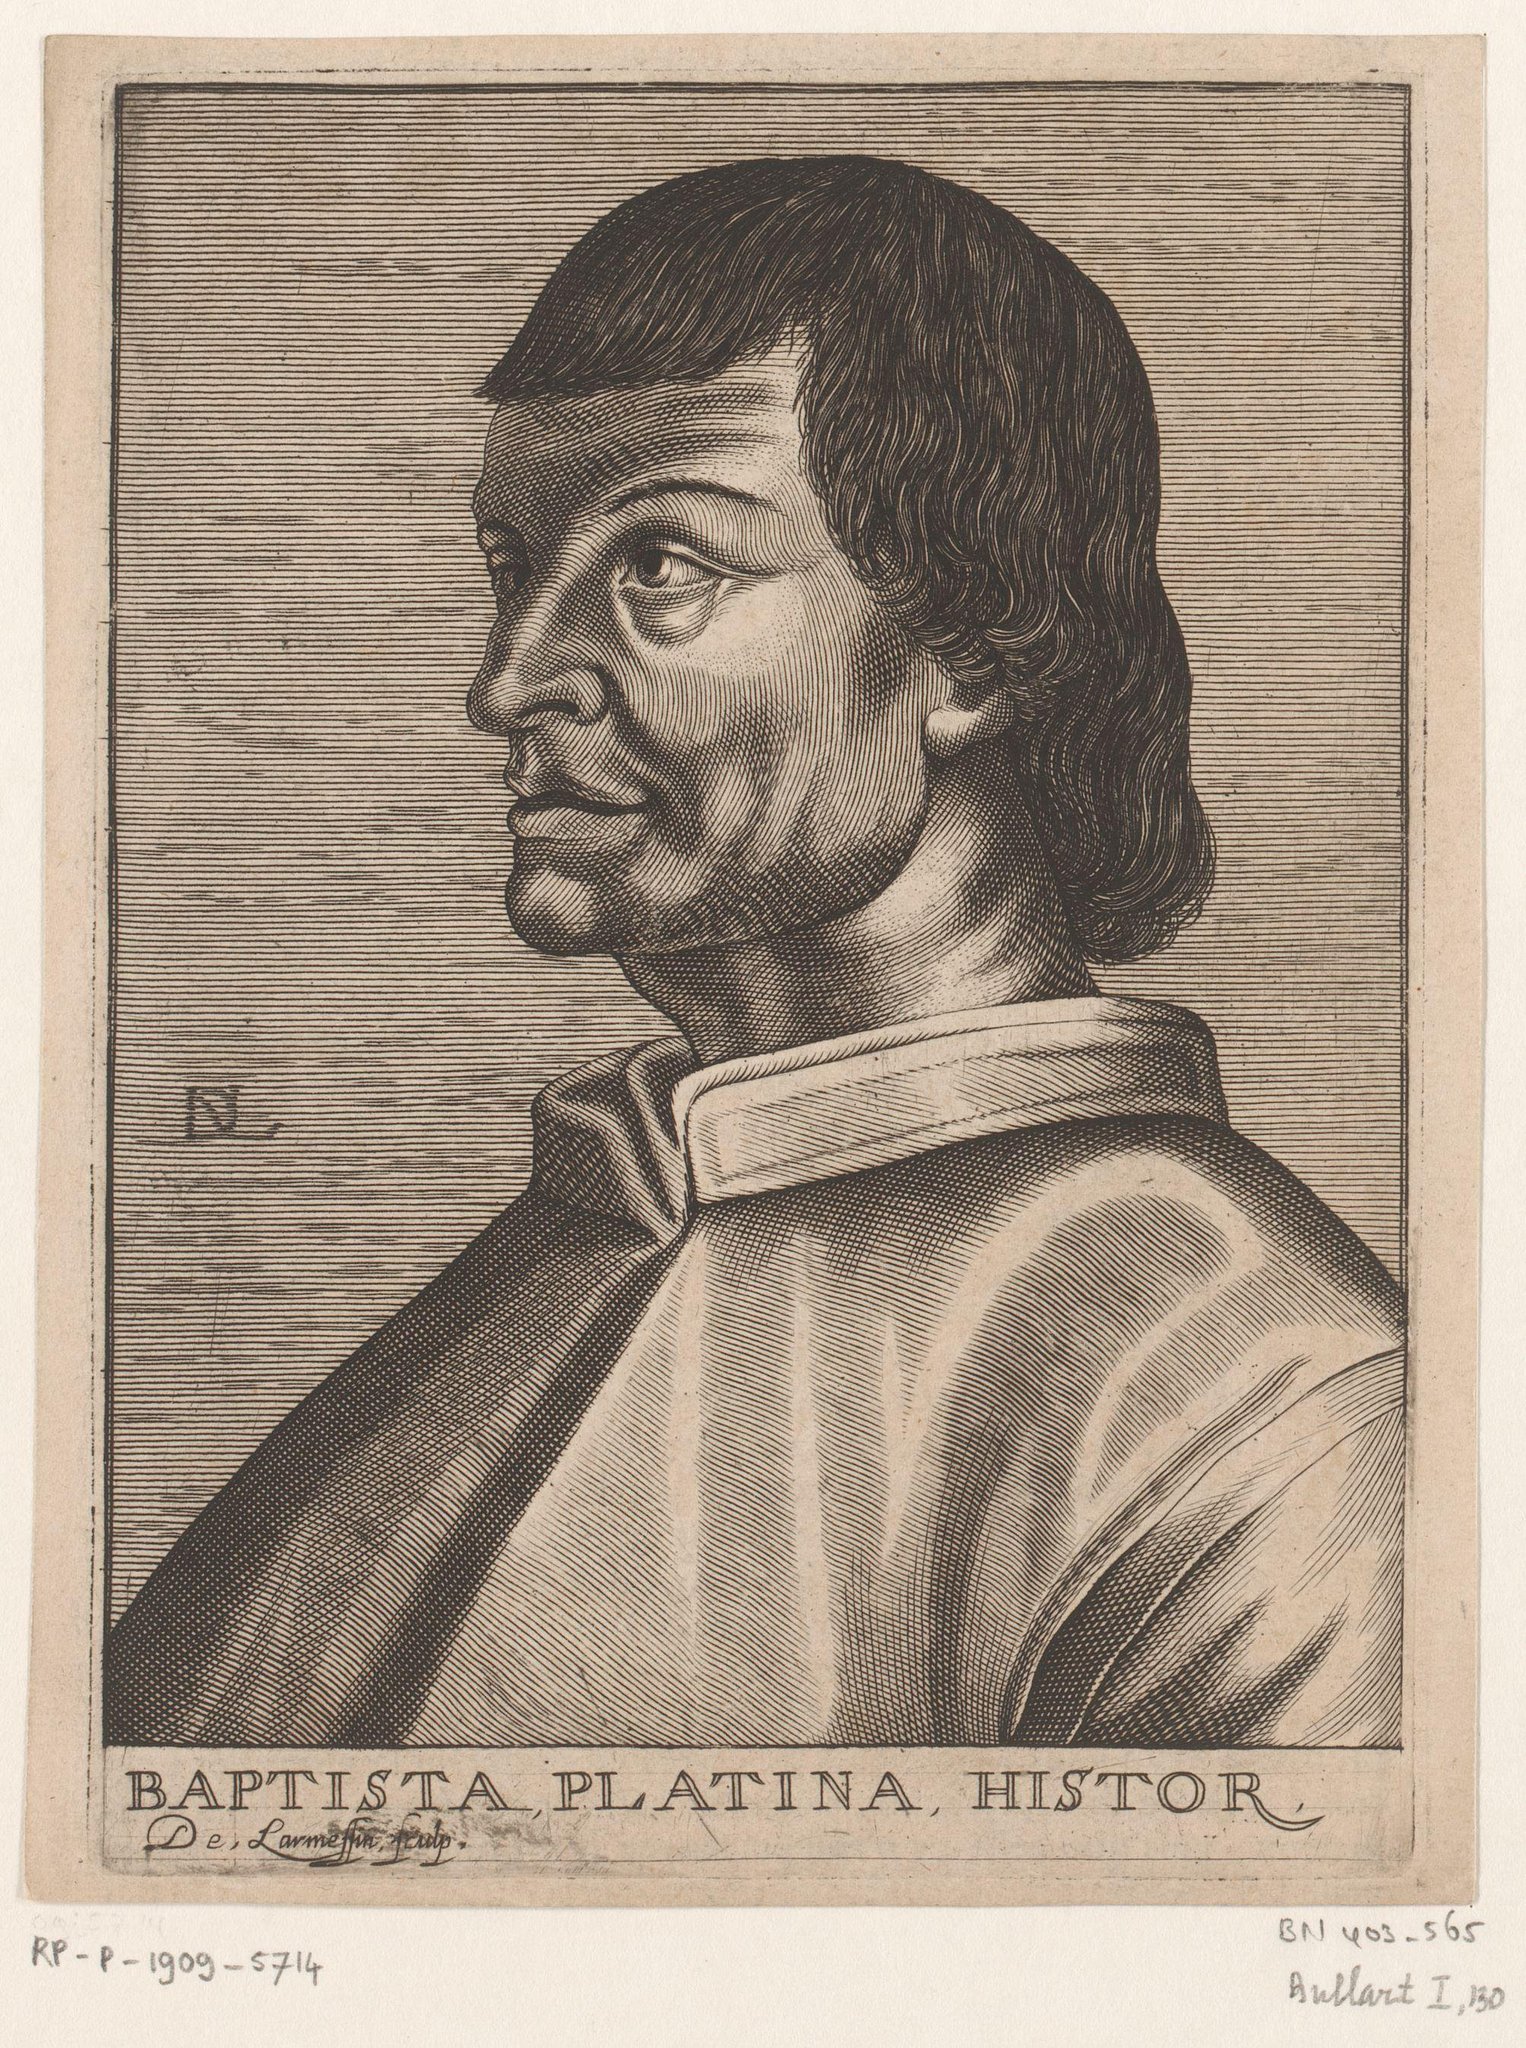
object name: book illustration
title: Baptista, Platina, Histor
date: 1682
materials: paper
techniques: engraving, letterpress printing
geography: brussels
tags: rome, historical persons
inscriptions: collector's mark: Lugt 2228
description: Prent gebruikt voor: Bullart, Isaac. Académie des Sciences et Arts contenant les vies et éloges his. des hommes illustres qui ont excellé en ces professions depuis environ quatre siècles. Brussel: François Foppens, 1682. Het boek werd in 1682 eveneens in Amsterdam uitgegeven door de erfgenamen van Daniel Elzevier. Ieder portret betreft een illustratie bij de biografie van een kunstenaar of geleerde. De meeste portretten werden door Nicolas de Larmessin vervaardigd (162), 93 door De Boulonois en een derde door ongeïdentificeerde prentmakers. Dit betreft een illustratie op p. 130, deel I.